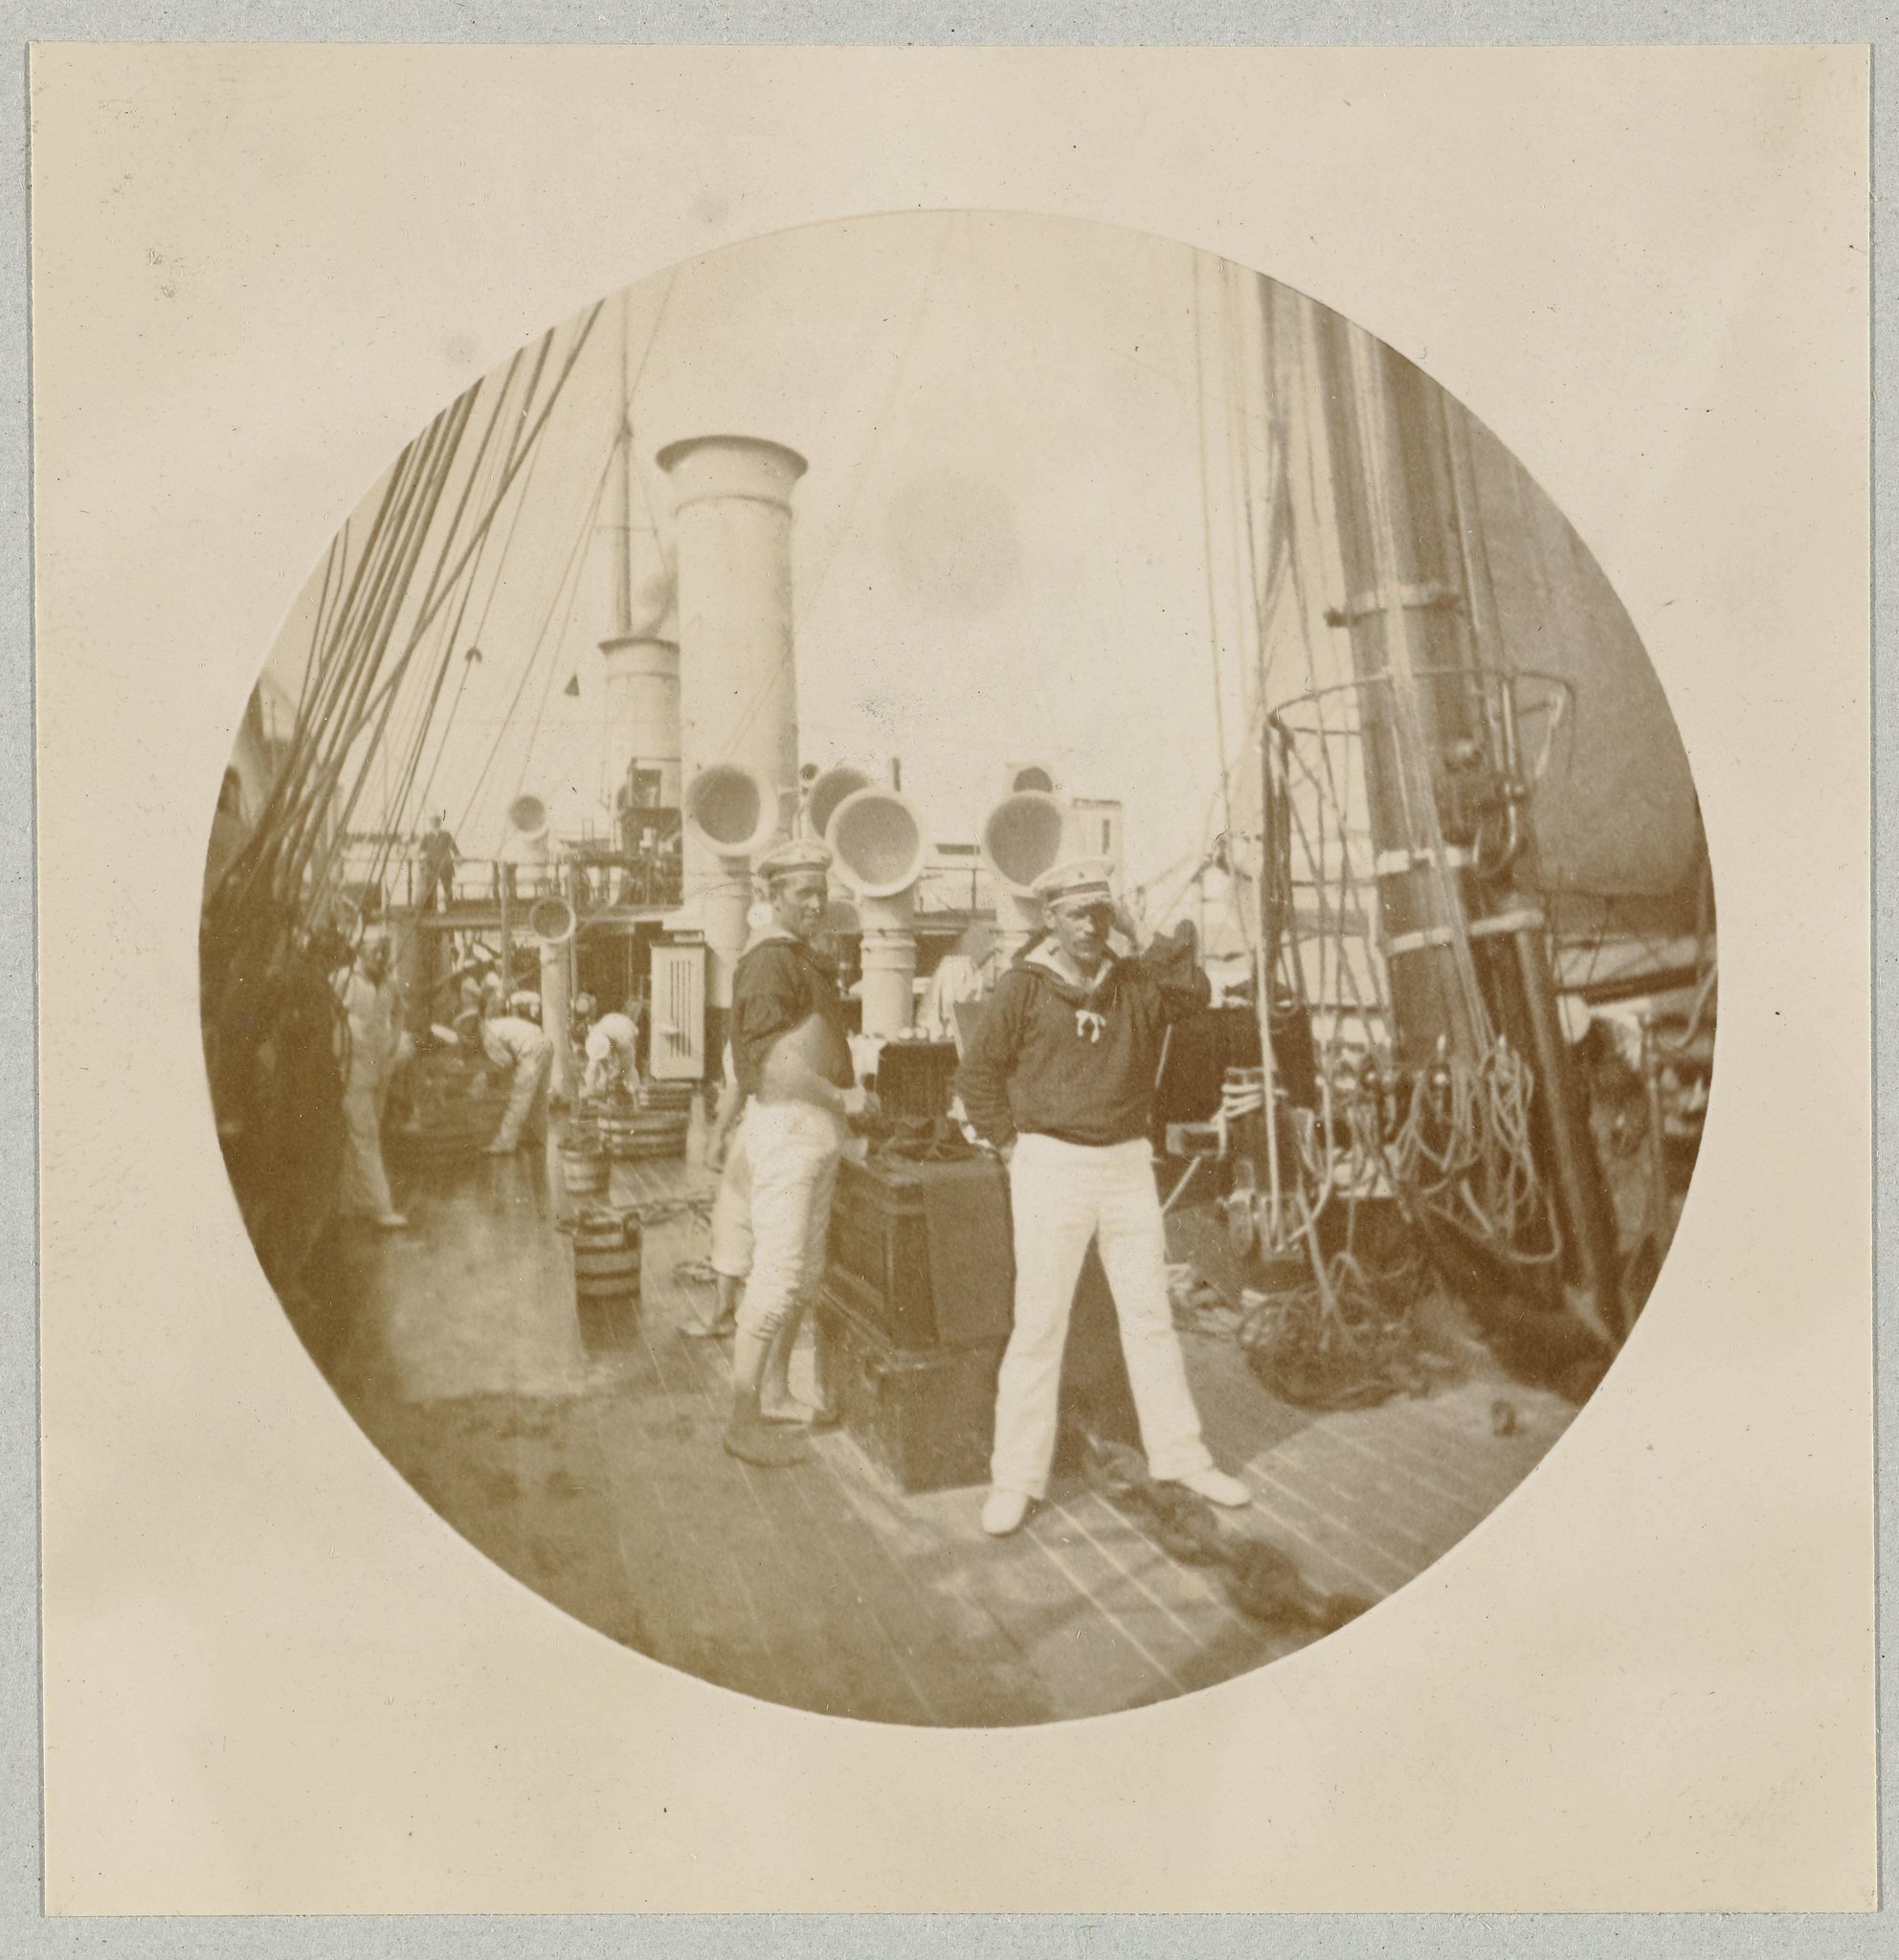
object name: photograph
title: Matrozen aan het werk op het zeilschip de Hohenzollern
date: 1807-1889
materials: cardboard, paper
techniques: gelatin silver print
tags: wilhelm ii (keizer van duitsland), norway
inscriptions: number: ‘12’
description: De afdruk van de foto is rond, het papier vierkant. foto gemaakt met Nr. 1 Kodak Camera